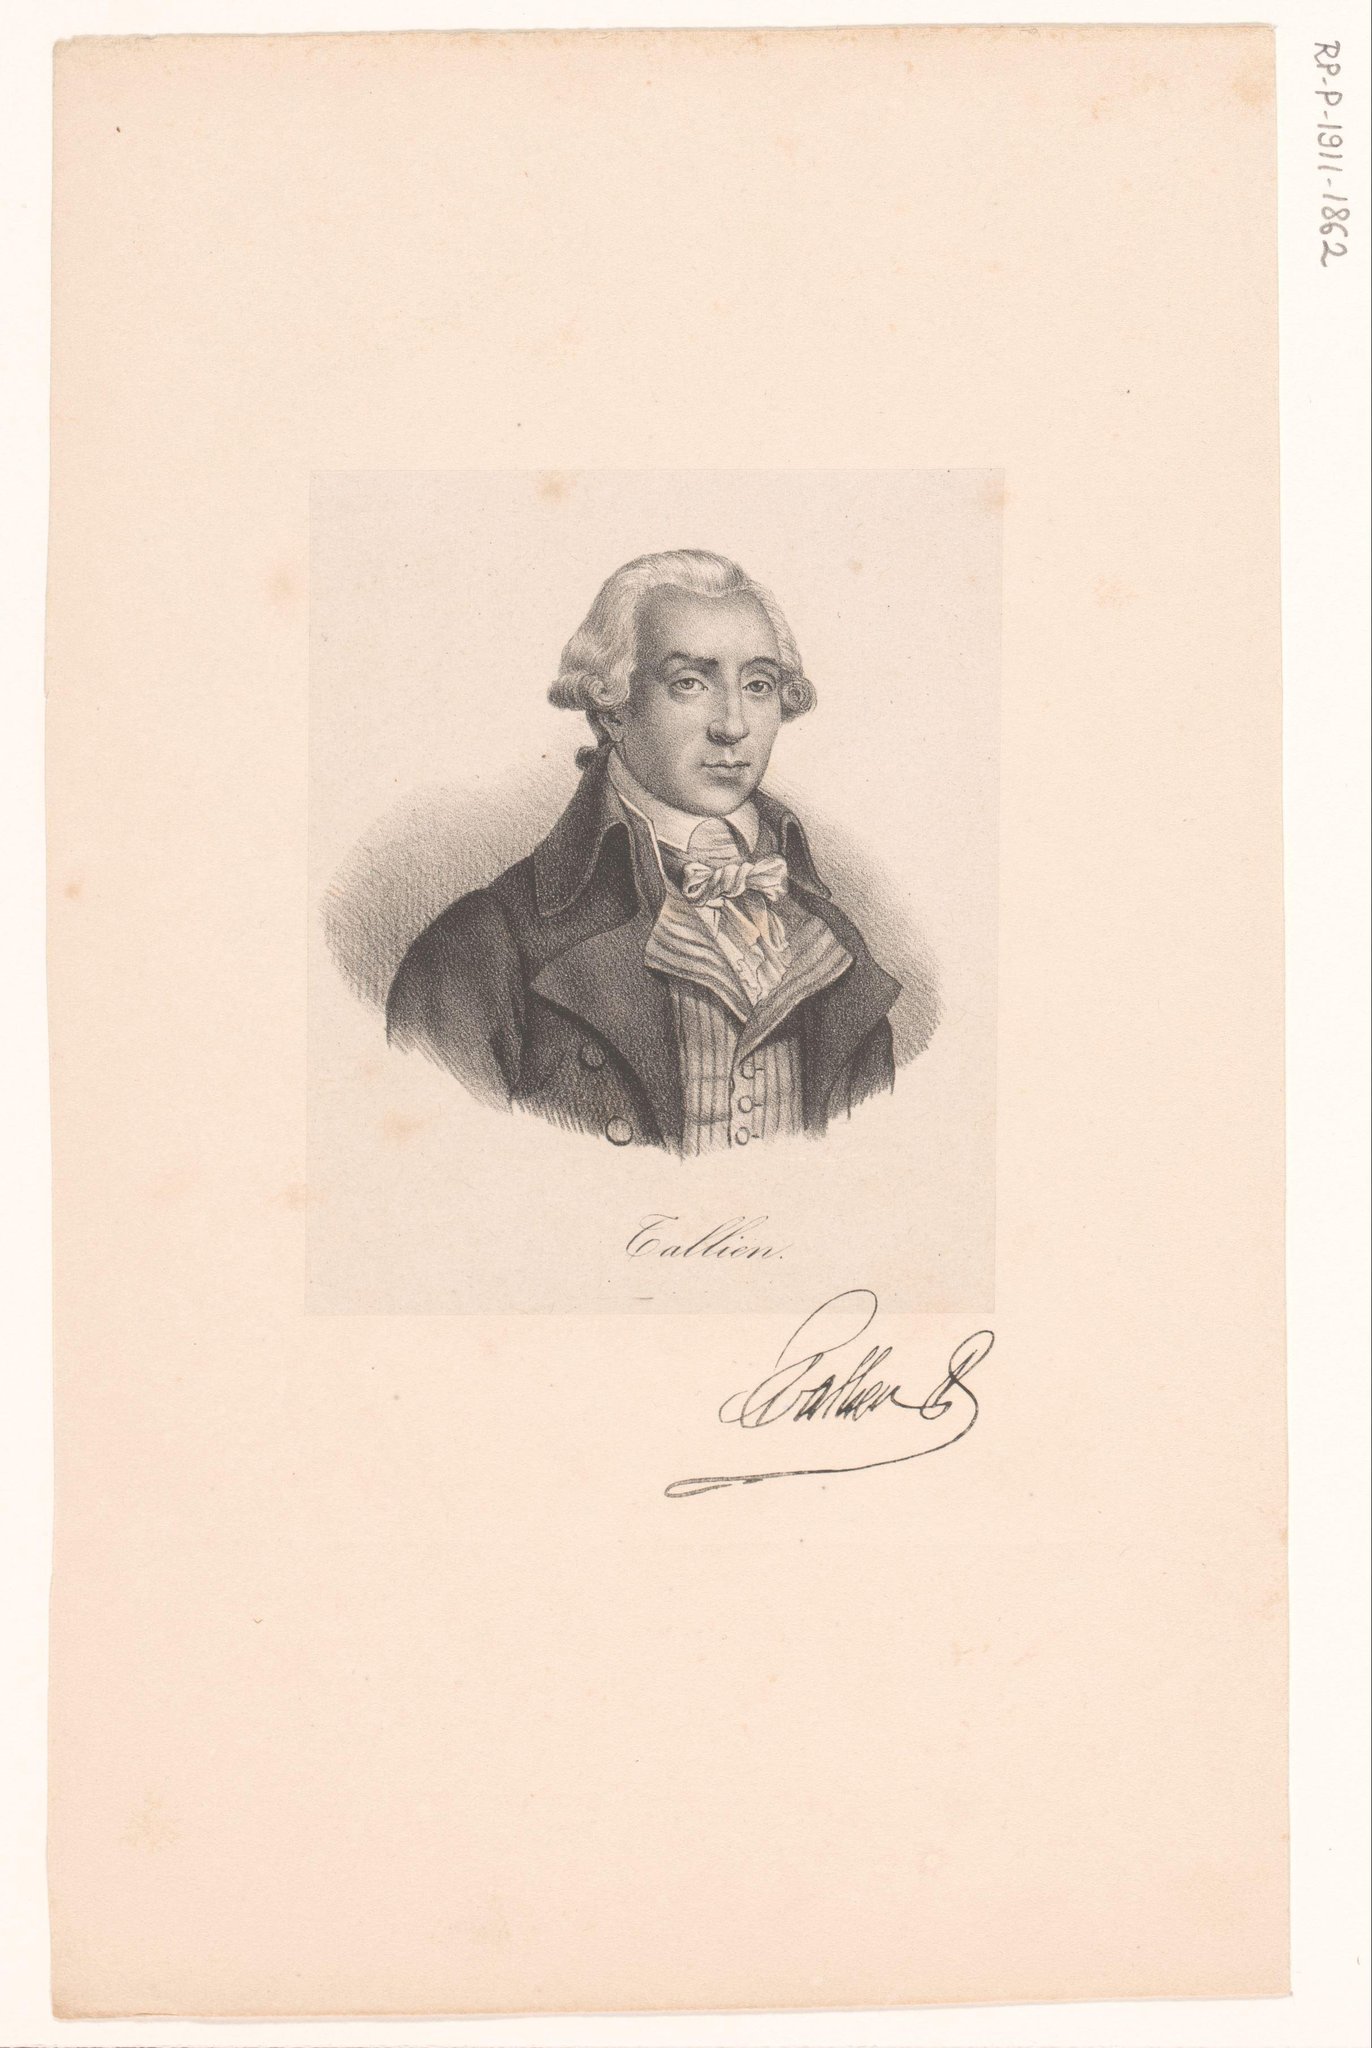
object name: print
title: Portret van Jean-Lambert Tallien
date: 1818-1842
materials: paper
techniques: lithograph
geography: paris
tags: historical persons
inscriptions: collector's mark: Lugt 2228a